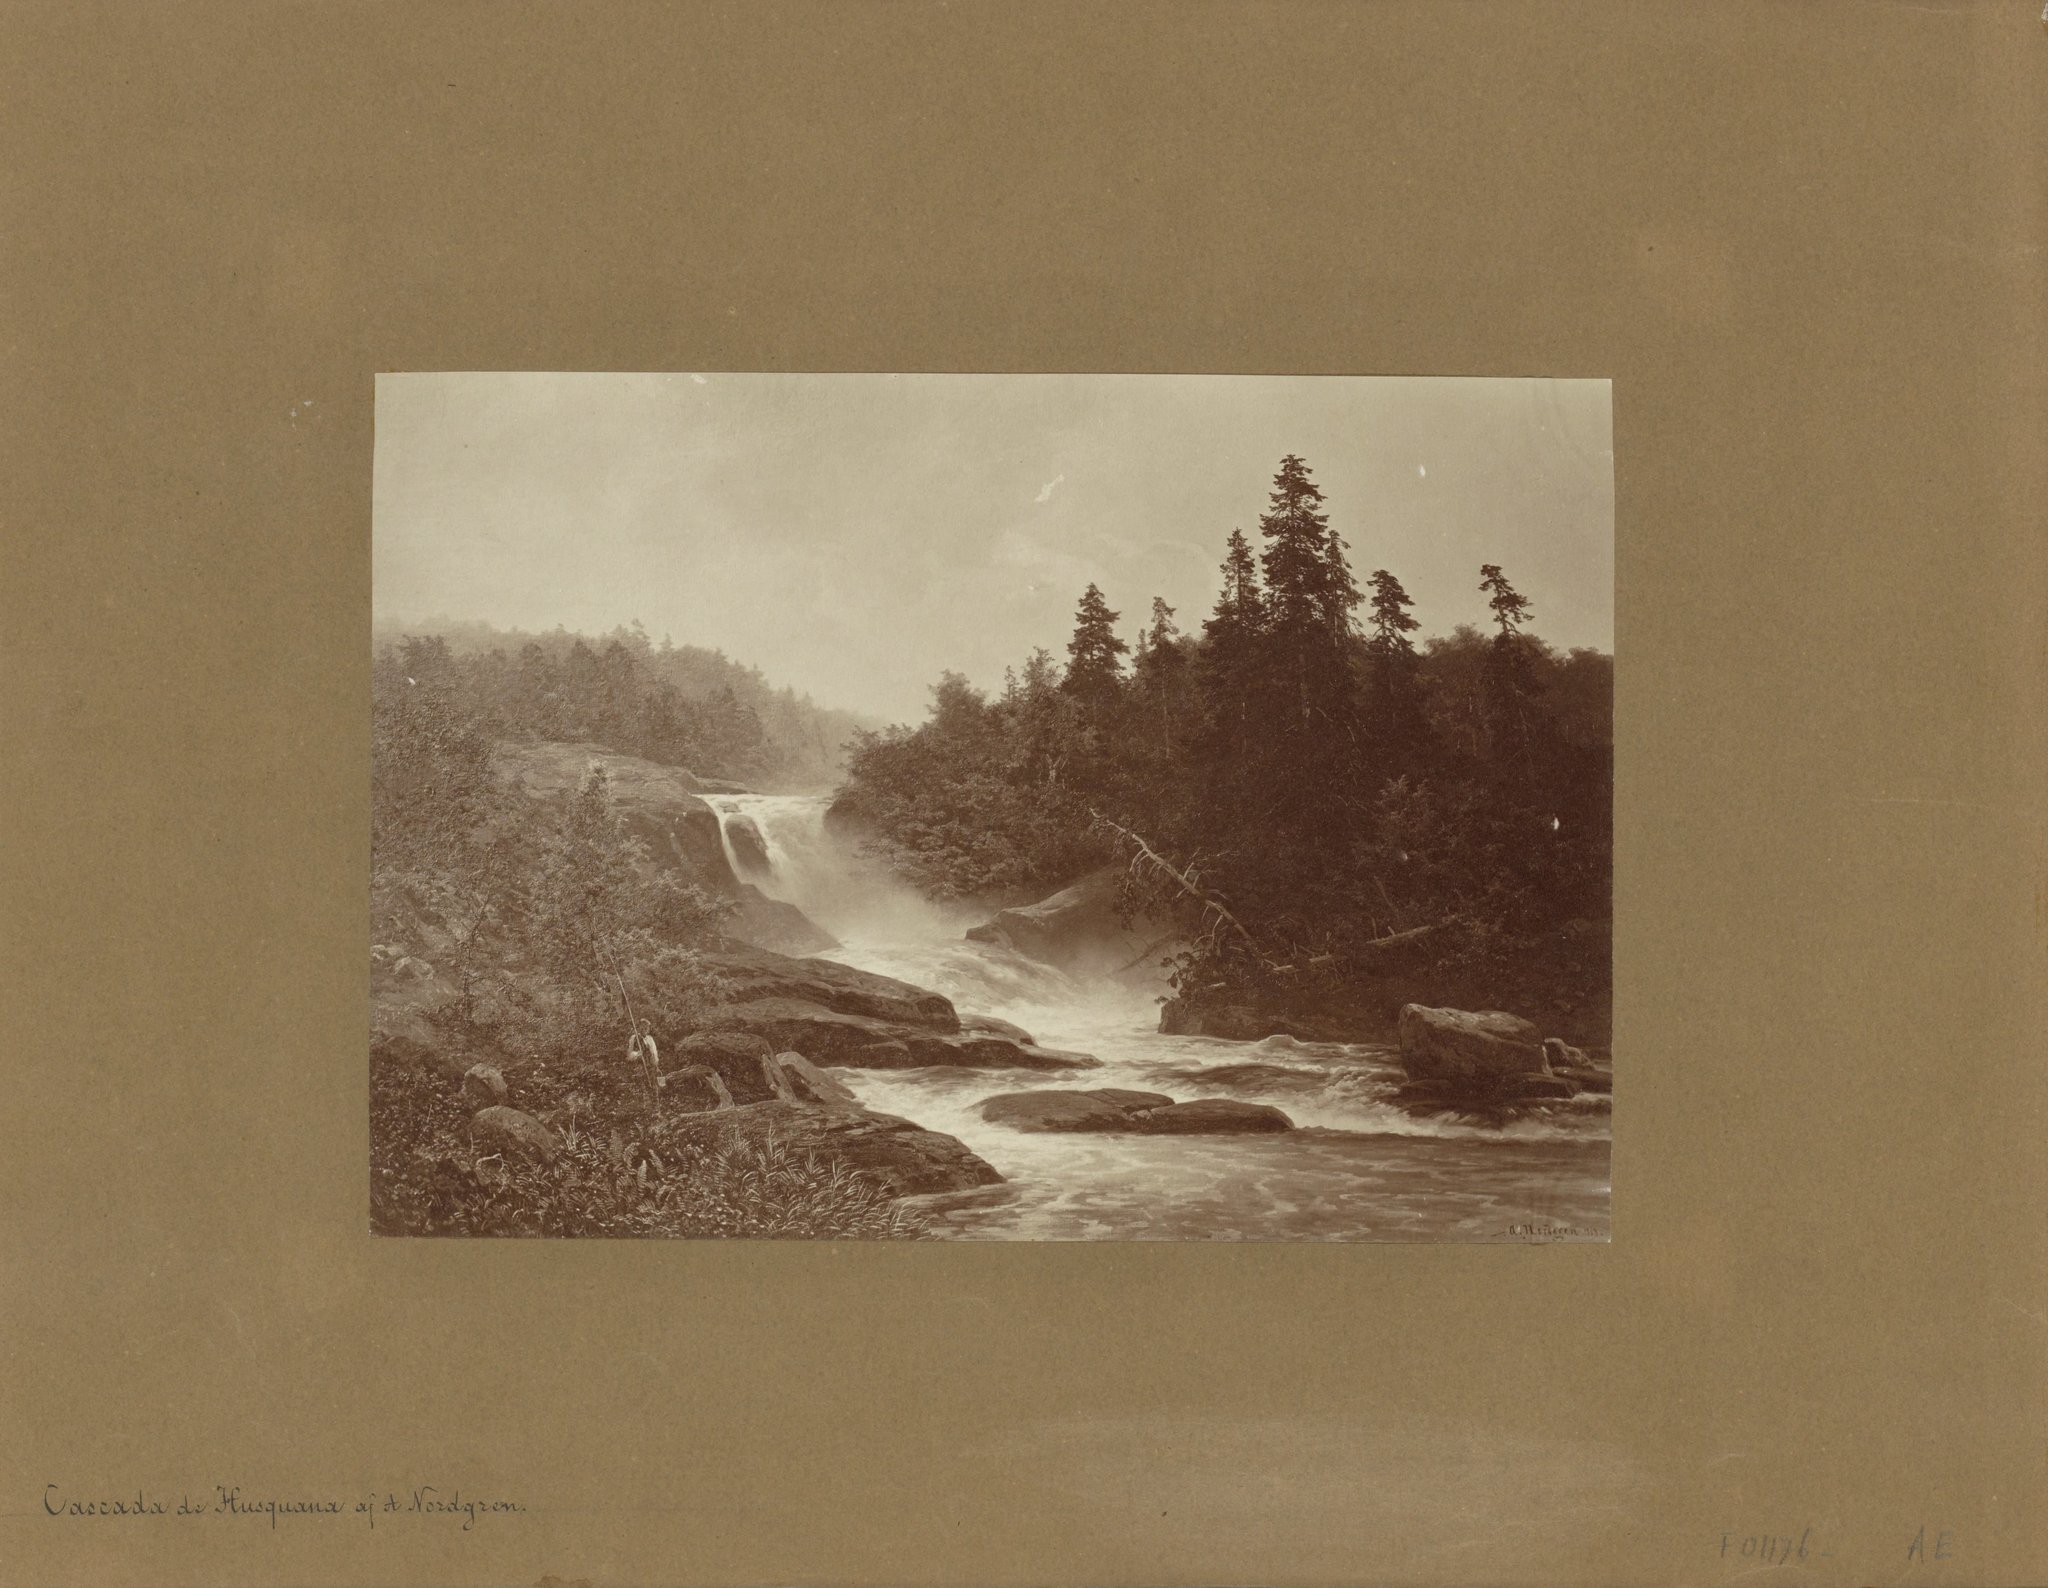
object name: photograph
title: Cascada de Husquana af A Nordgren.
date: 1863-1876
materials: photographic support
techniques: albumen print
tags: waterfall, travelling; tourism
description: Onderdeel van Reisalbum met foto's en tekeningen van Manuel Mayo 1876.